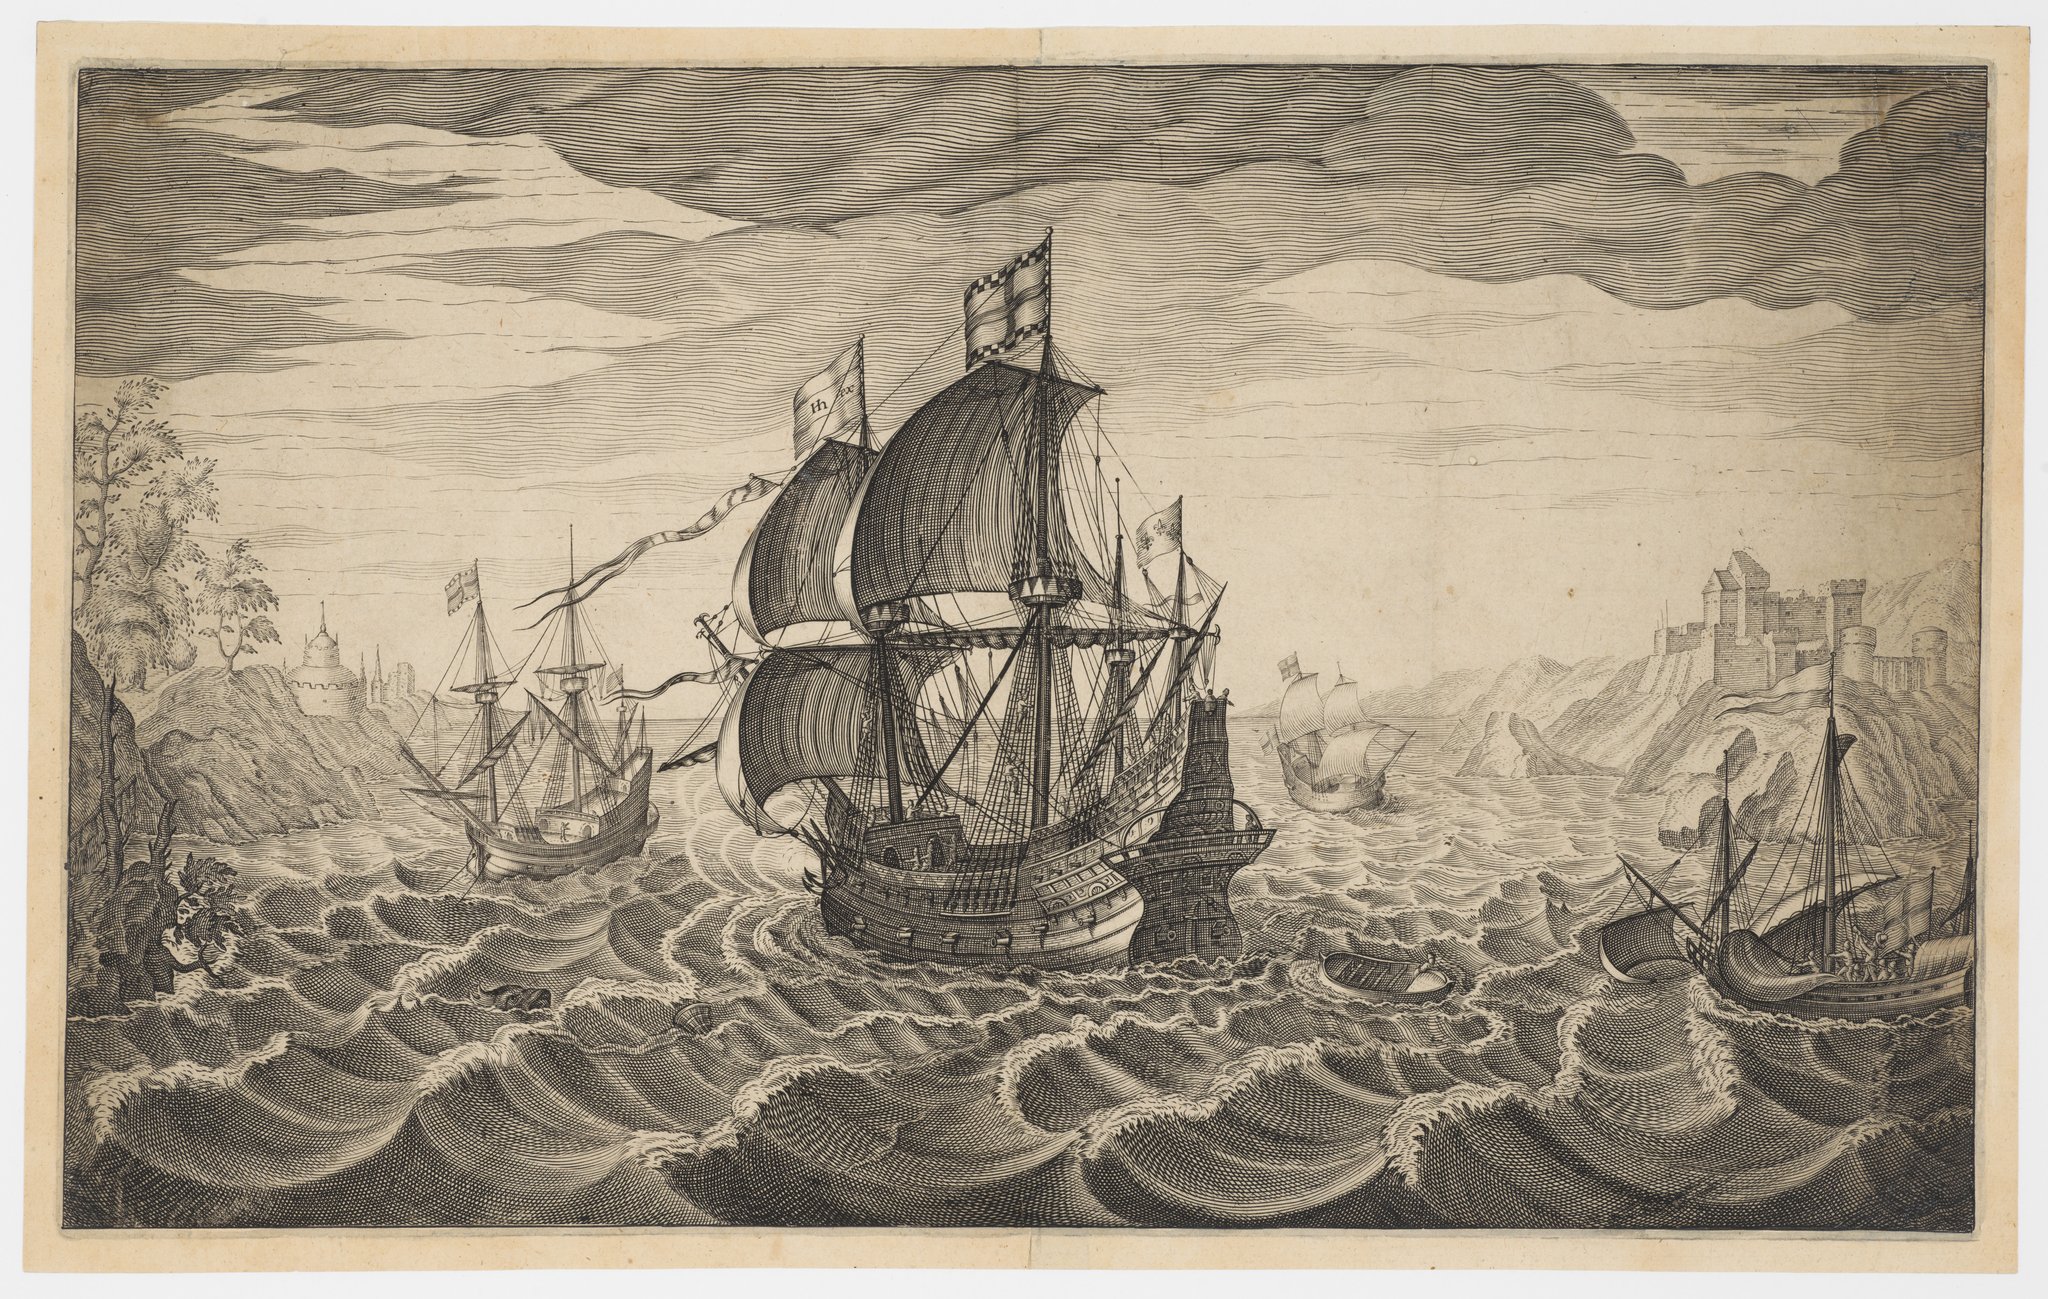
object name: print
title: Four Sailing Ships on Choppy Seas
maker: robert willemsz de baudous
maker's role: artist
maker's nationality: netherlandish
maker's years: 1574-1659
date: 1603-1630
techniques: engraving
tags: ships